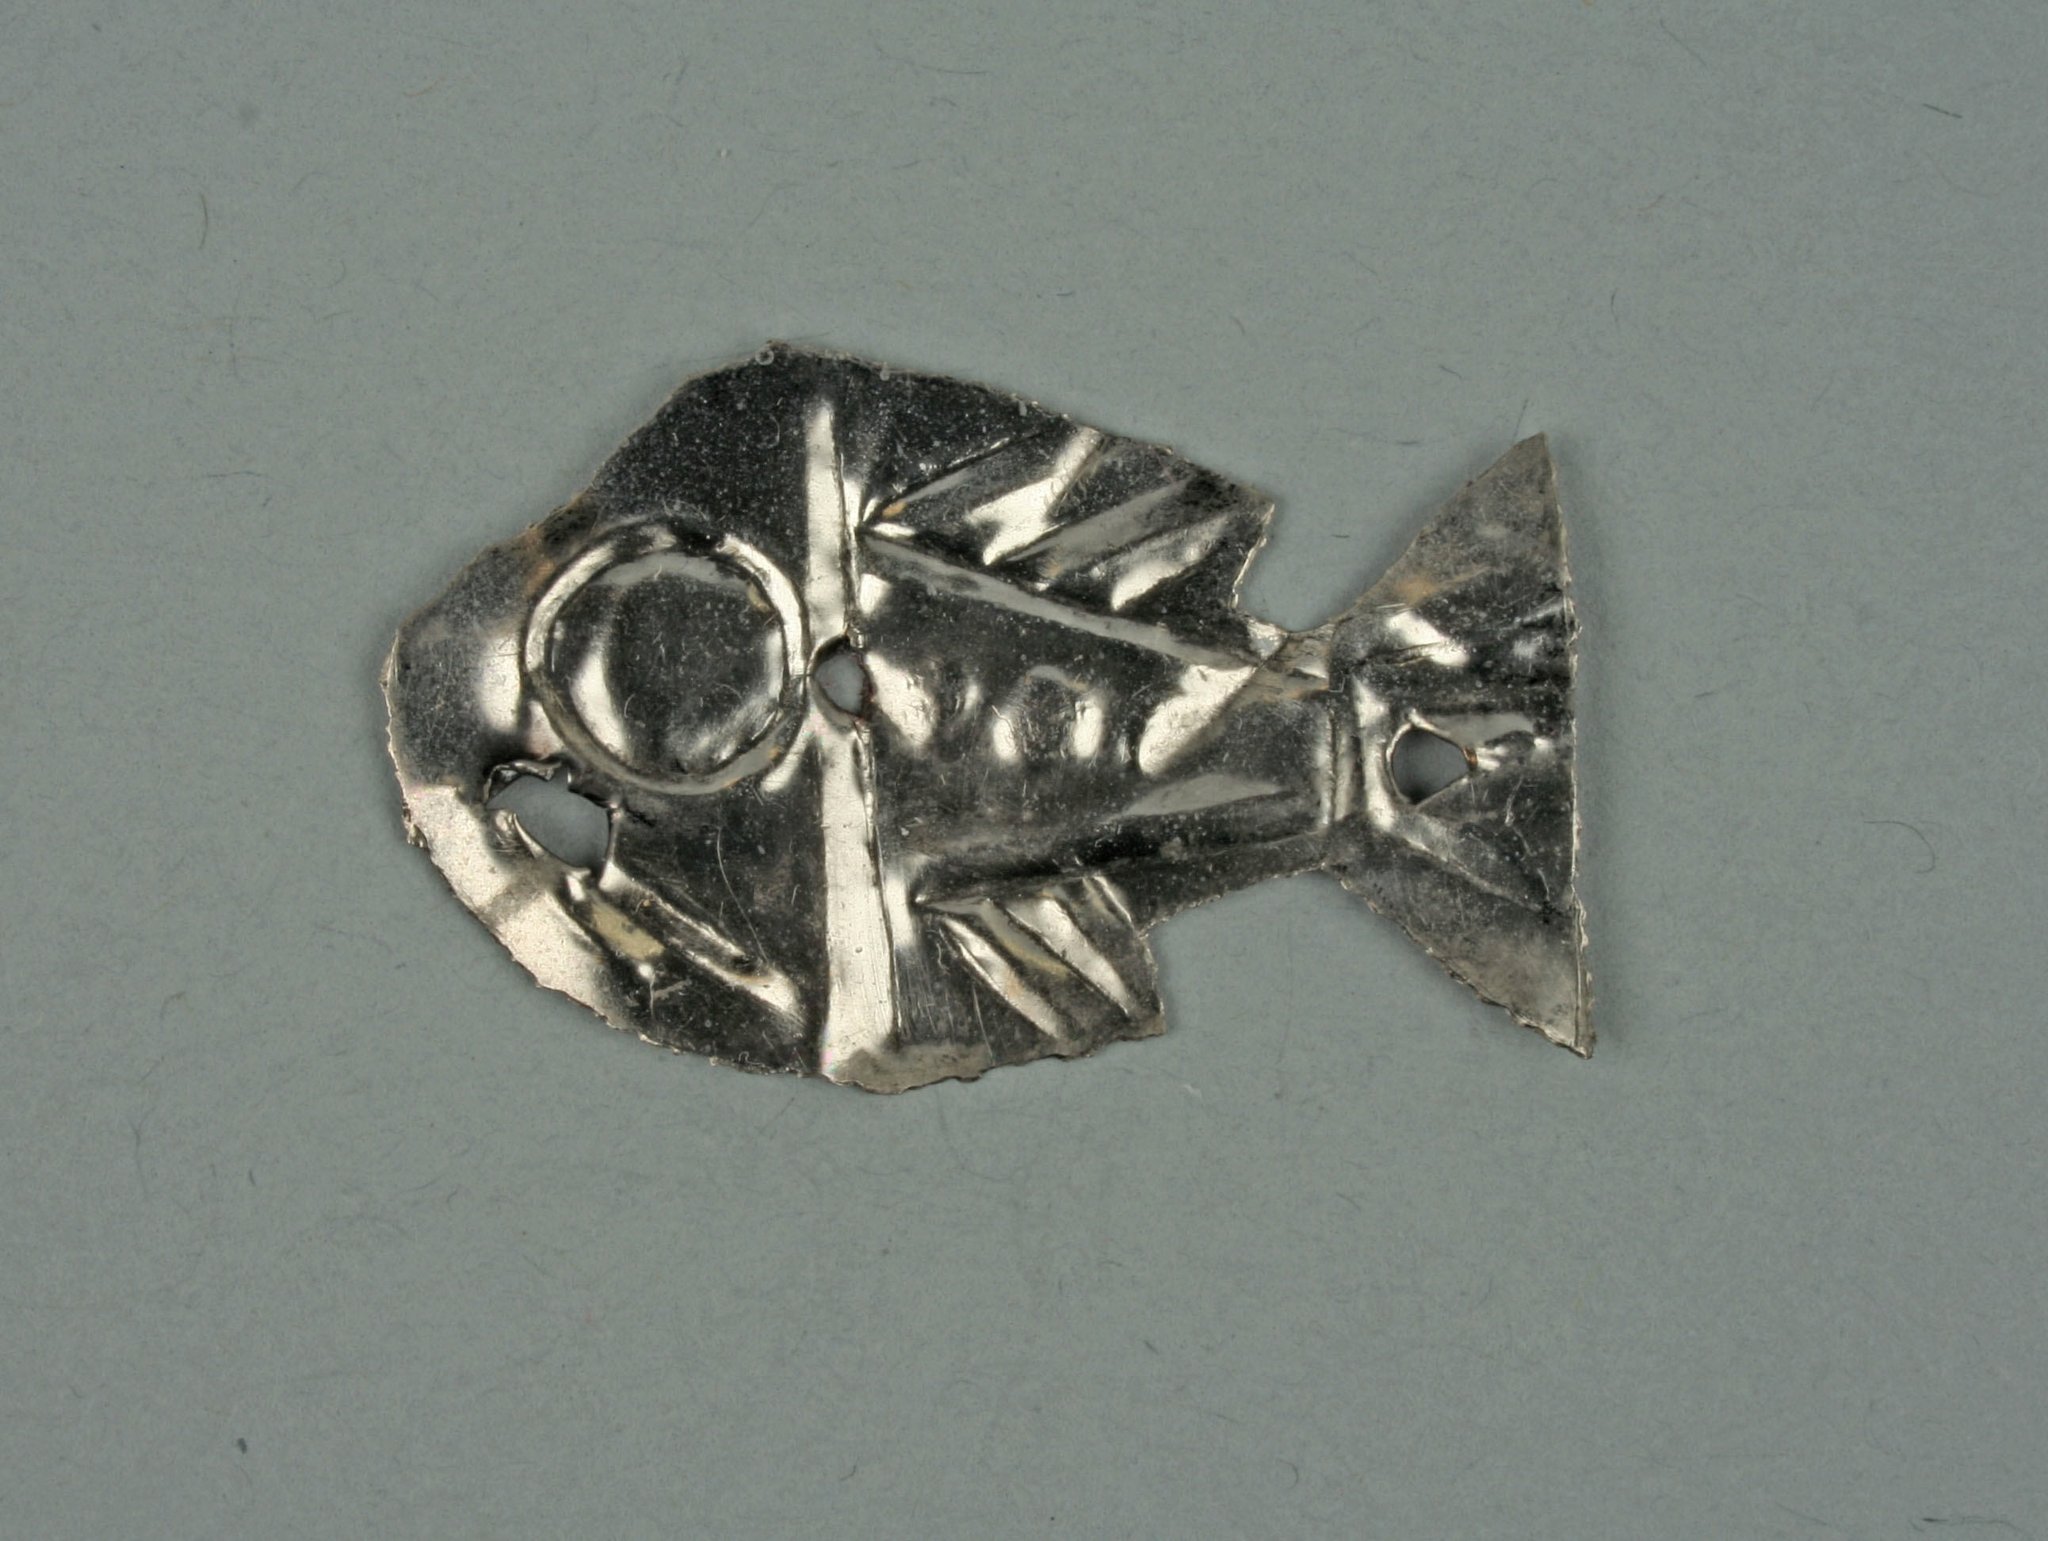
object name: ornament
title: Fish Ornament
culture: peruvian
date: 1001-1200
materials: silver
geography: peru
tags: fish